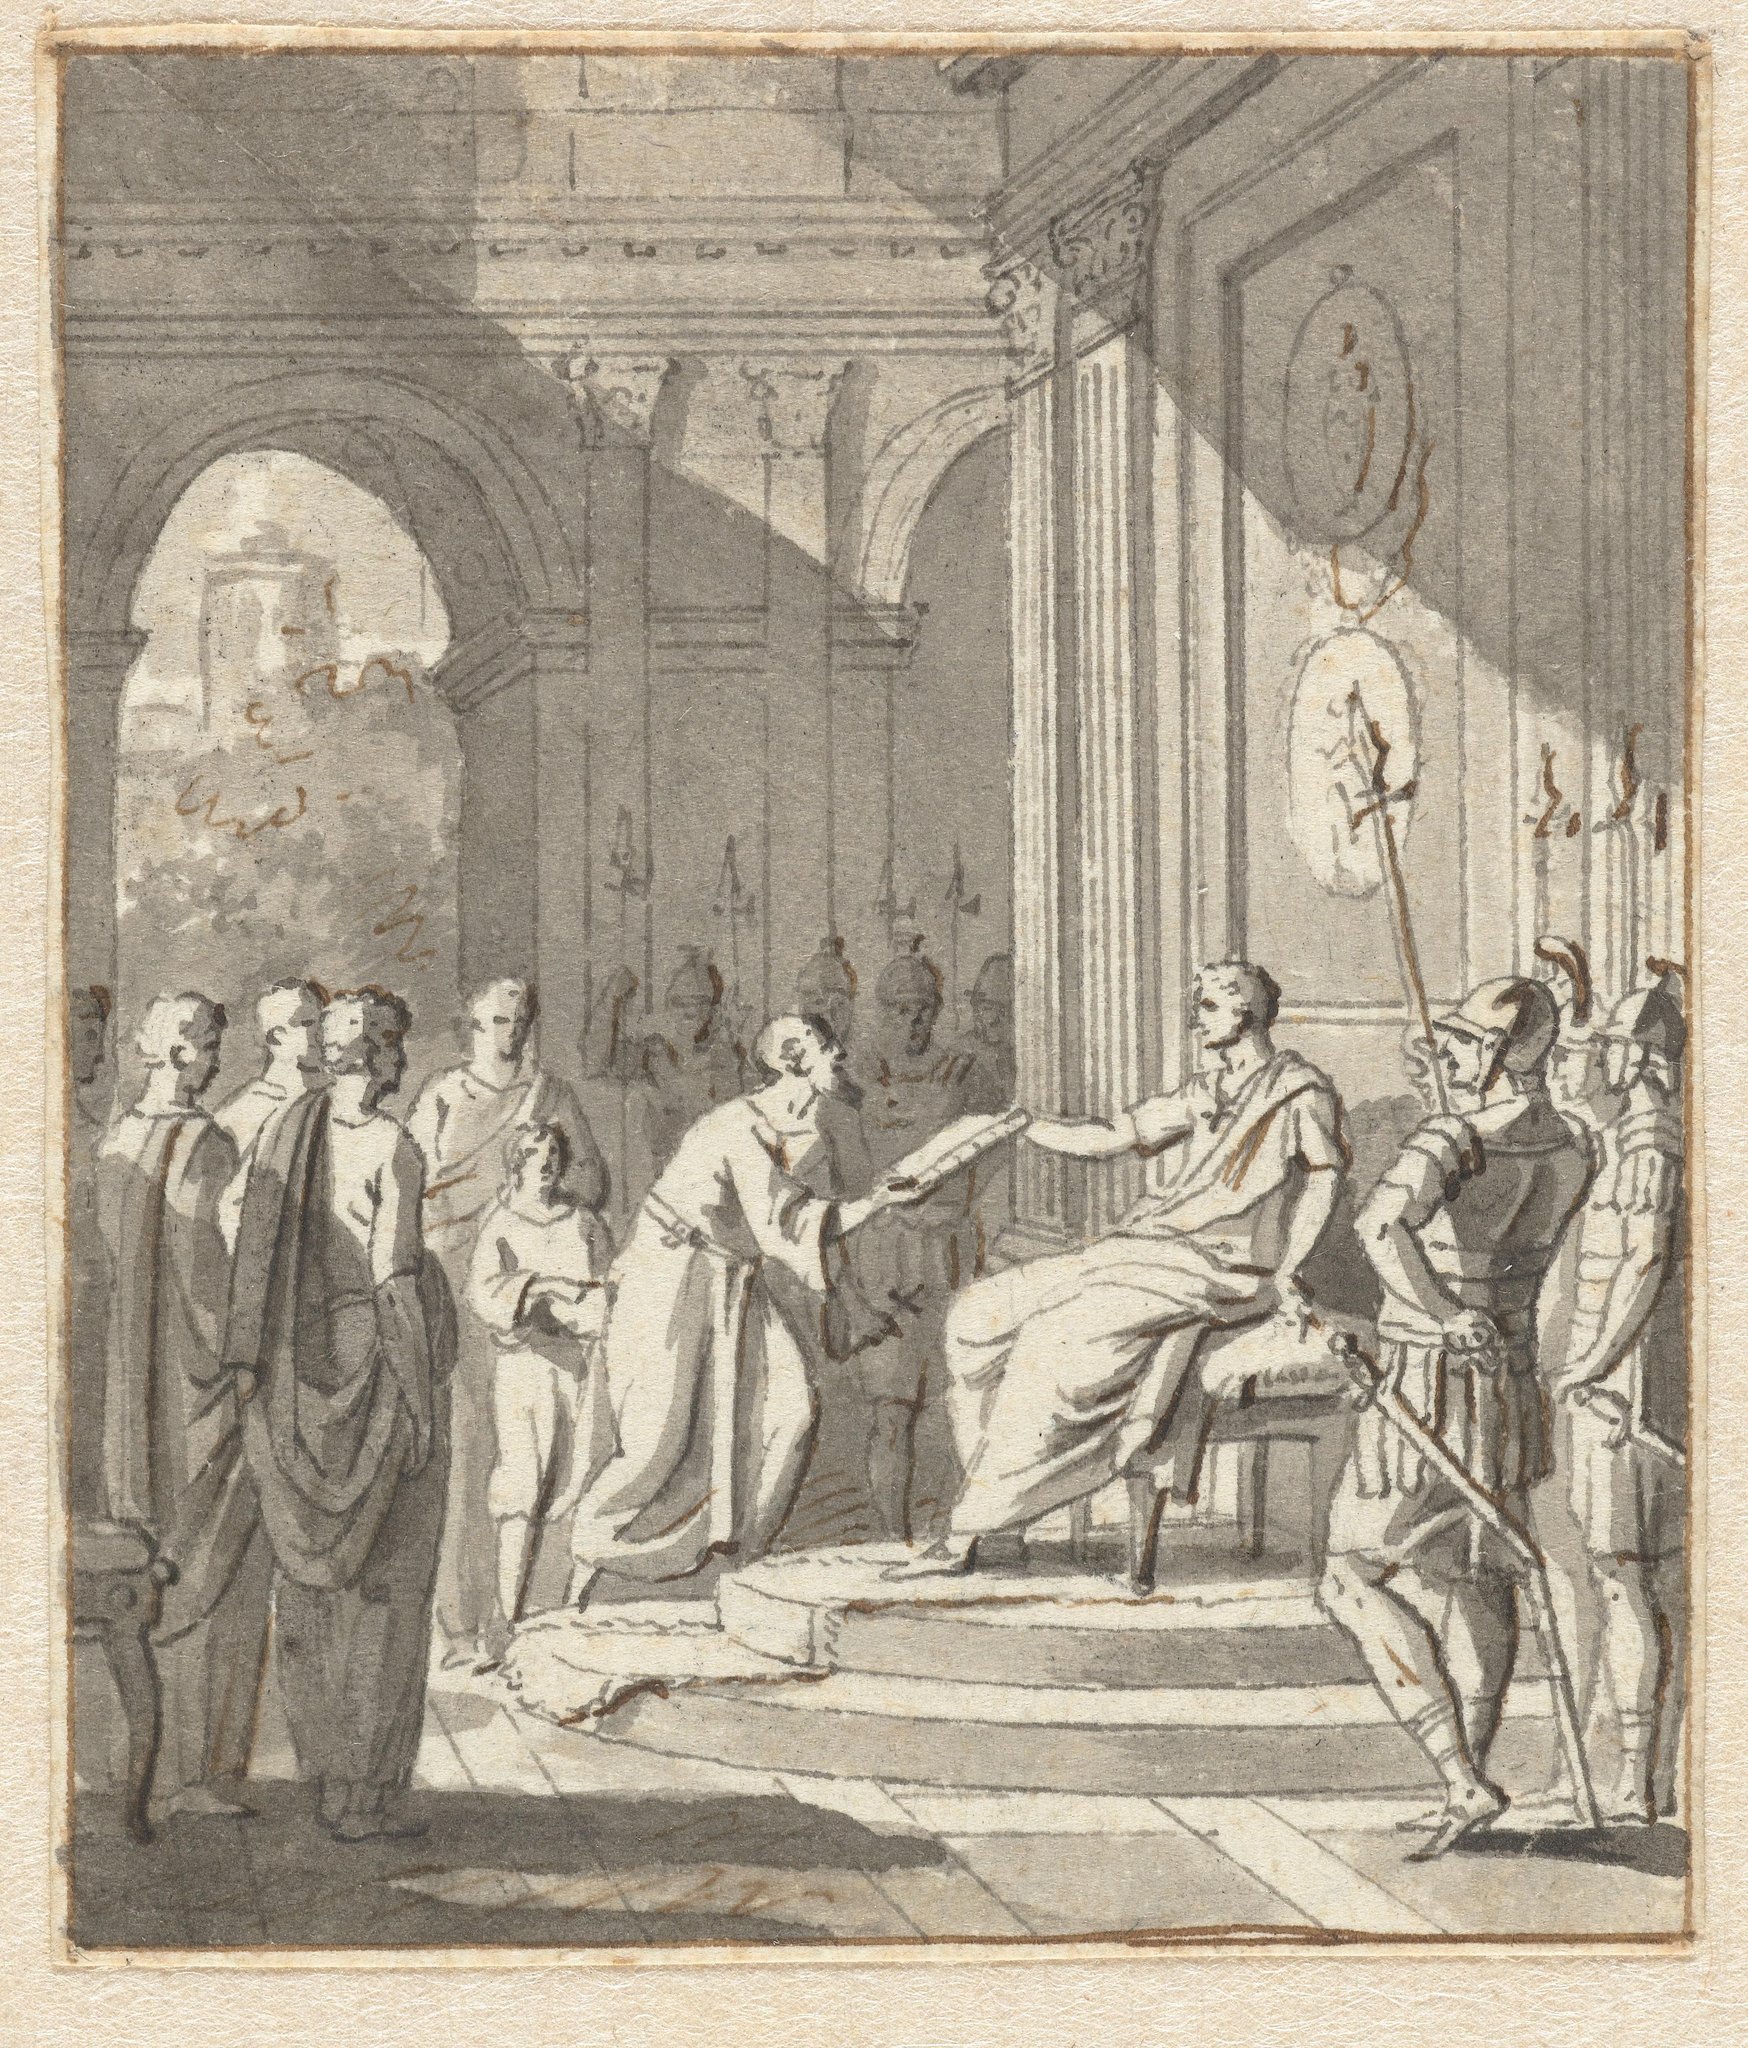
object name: drawing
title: In 't Jaar 690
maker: Anonymous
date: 1789-1810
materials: ink, paper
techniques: brush, pen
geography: netherlands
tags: merovingische en karolingische tijd in nederland